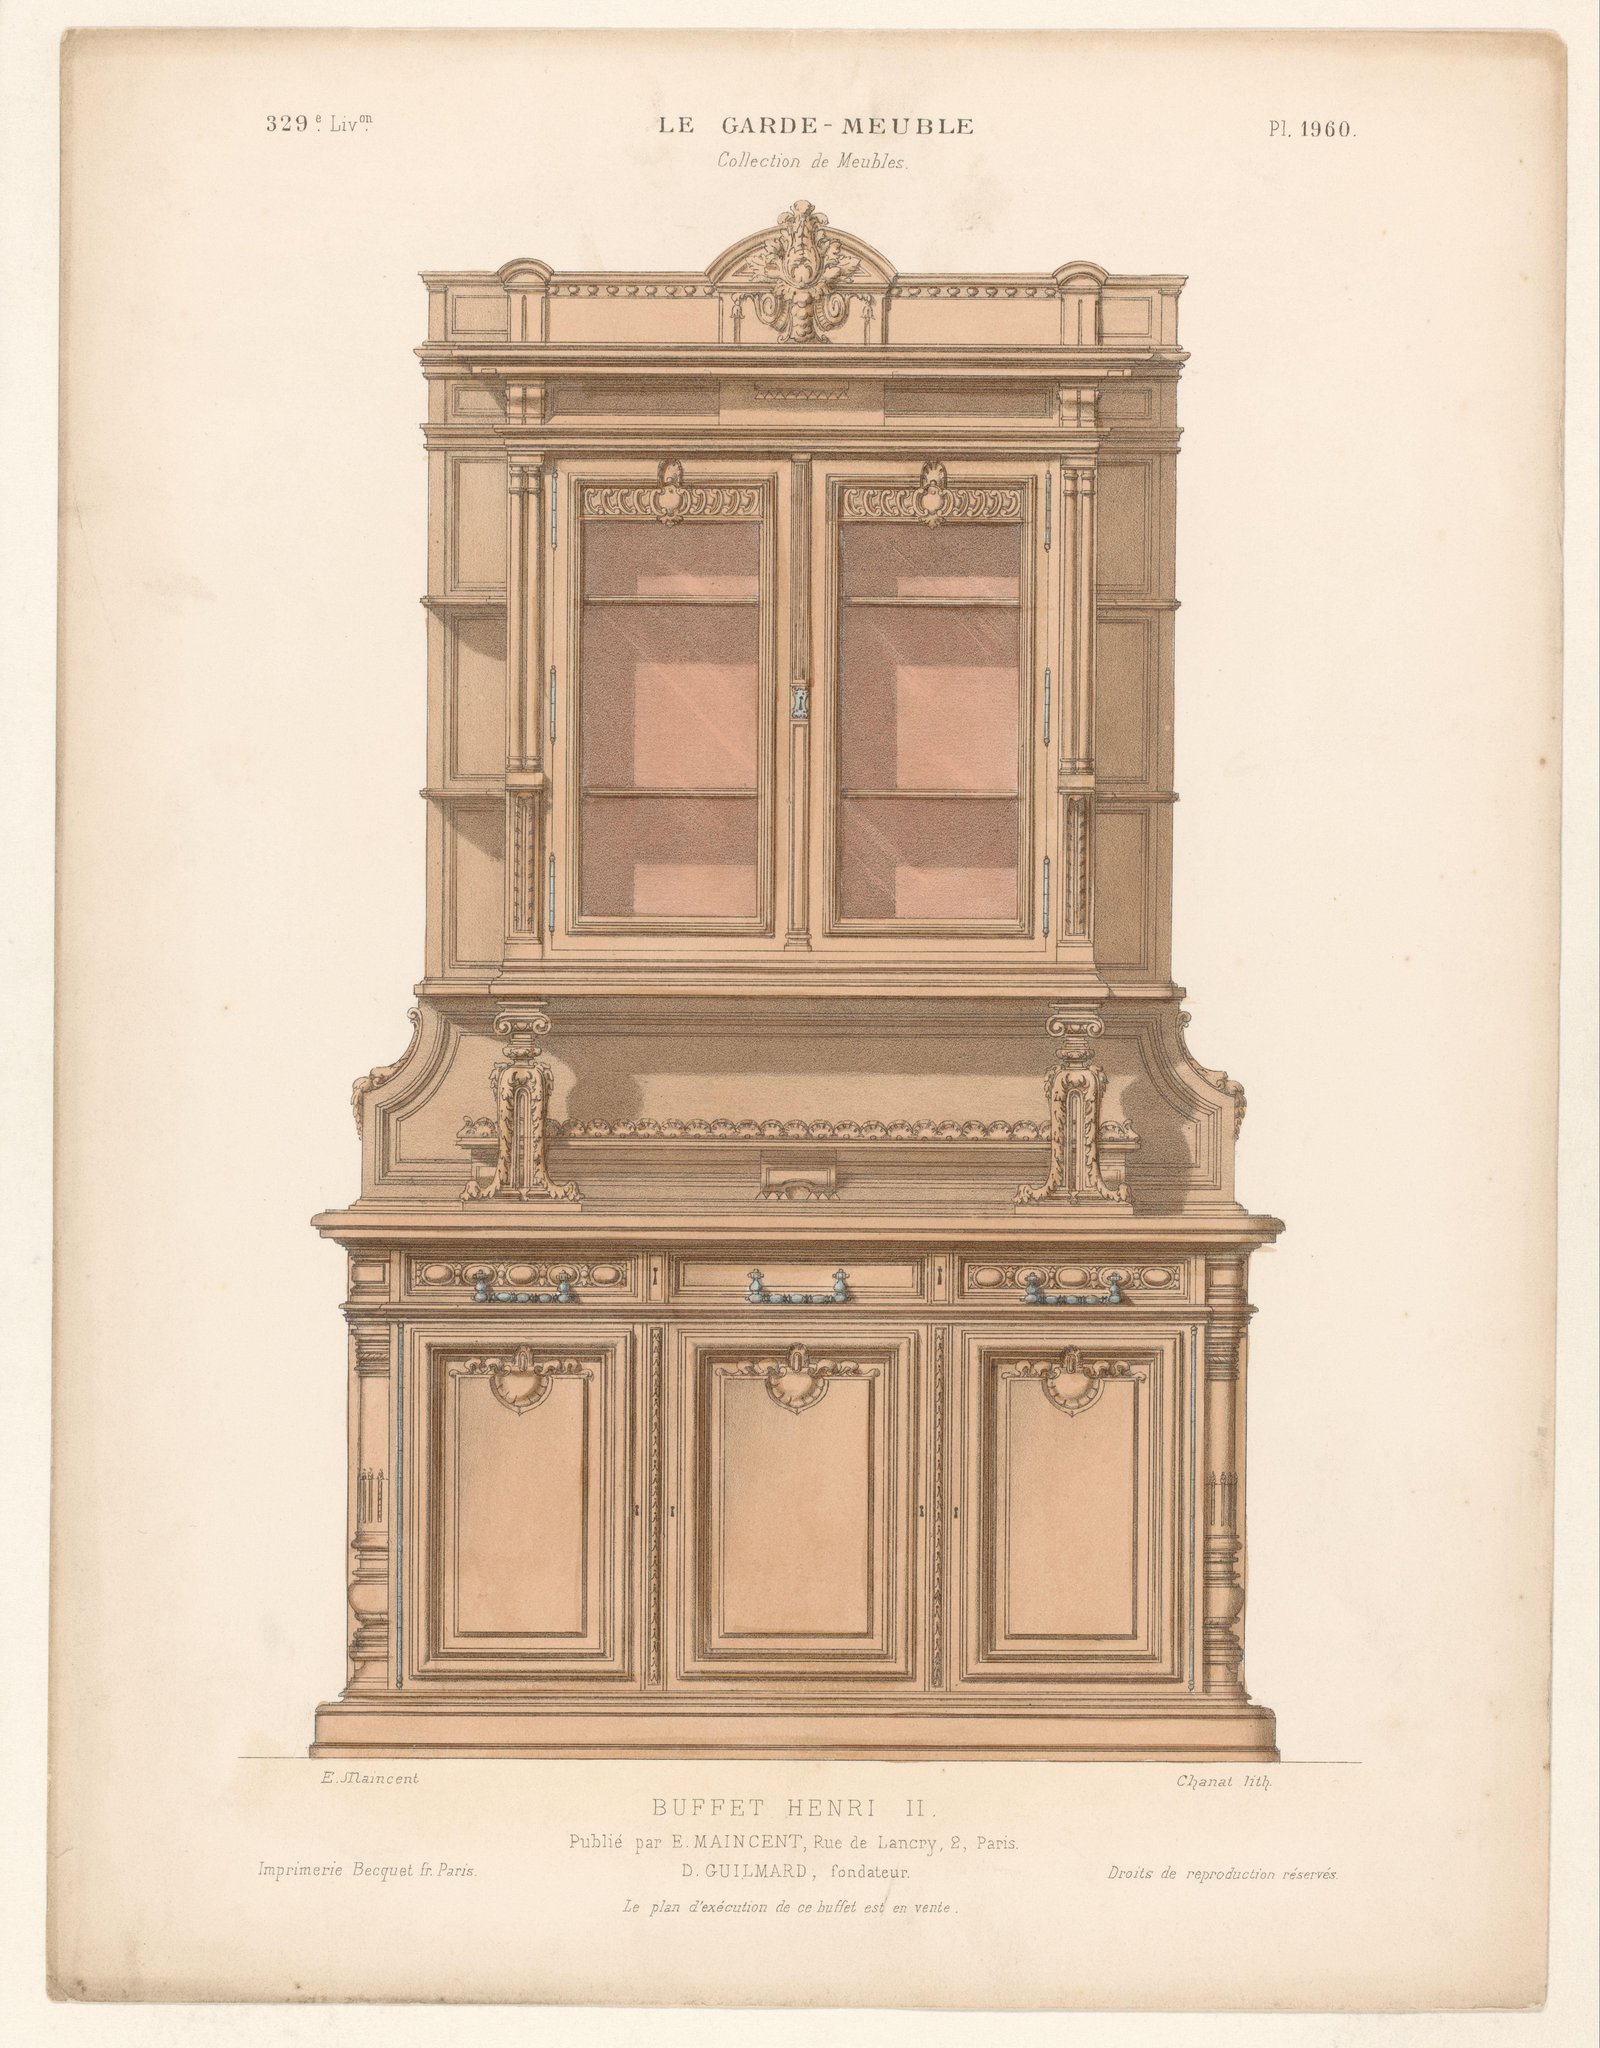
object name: print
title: Buffet Henri II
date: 1885-1895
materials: paper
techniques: hand coloring, lithograph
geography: paris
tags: furniture for storage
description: Ieder Livraison in de serie Le Garde-Meuble bevat negen platen: drie 'sièges' (zitmeubels), drie 'meubles' (diverse meubels zoals tafels en kasten) en drie 'tentures' (gordijnen en draperieën).